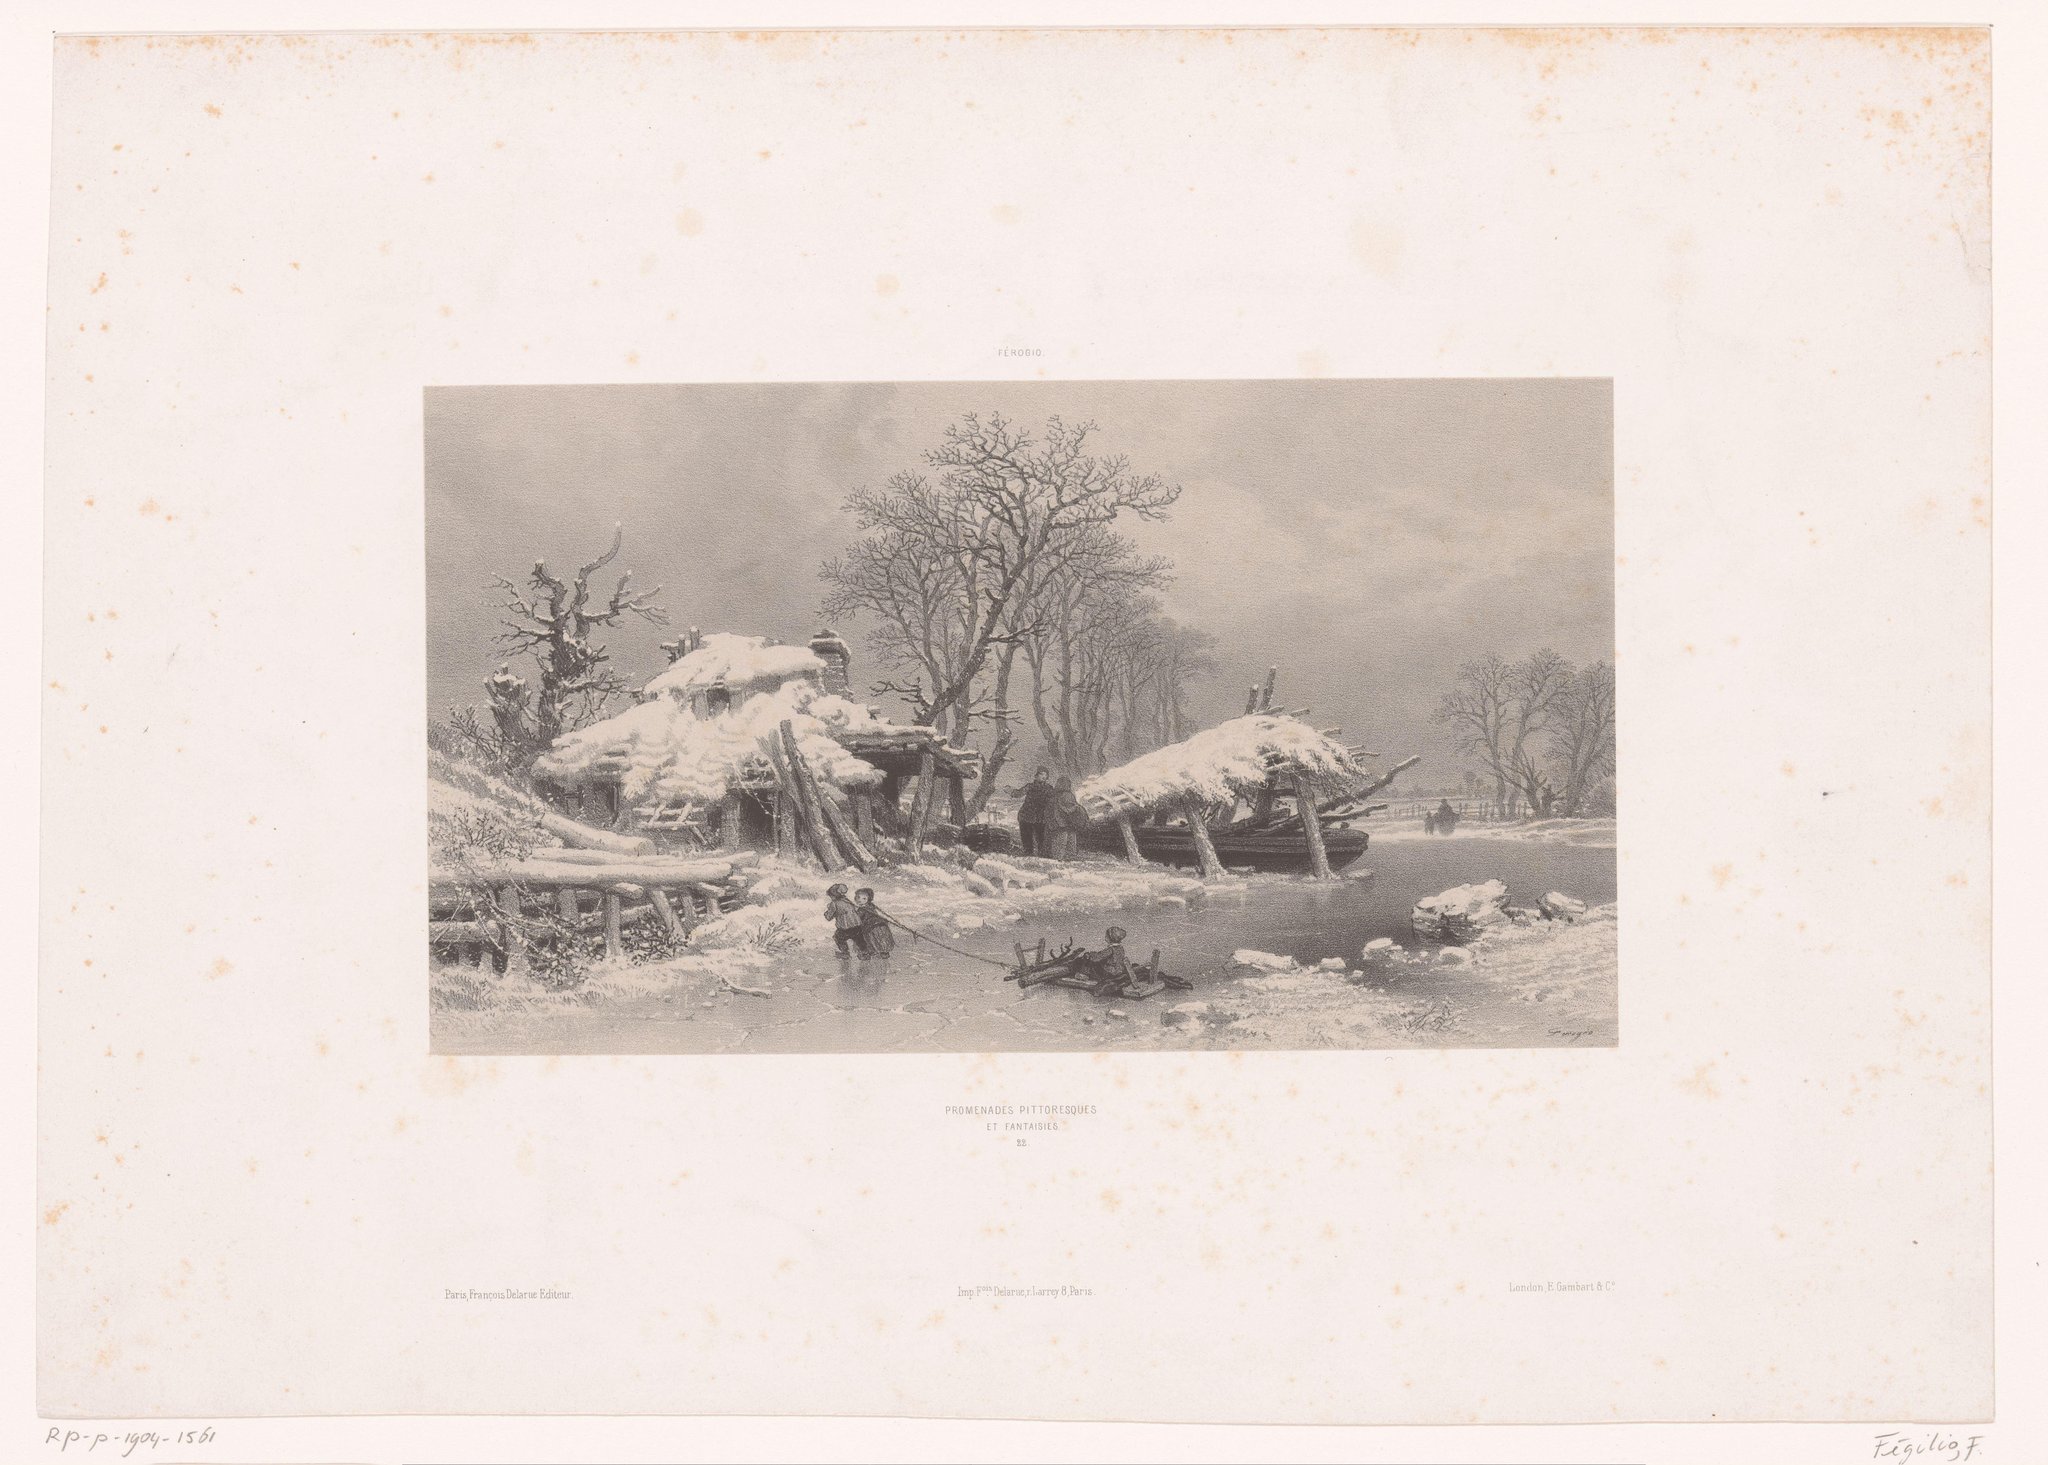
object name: print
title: Promenades pittoresques et fantaisies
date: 1852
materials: paper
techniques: lithograph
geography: paris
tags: ice ~ freezing weather, snow, sliding (playing with snow and ice), farm or solitary house in landscape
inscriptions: collector's mark: Lugt 2228a